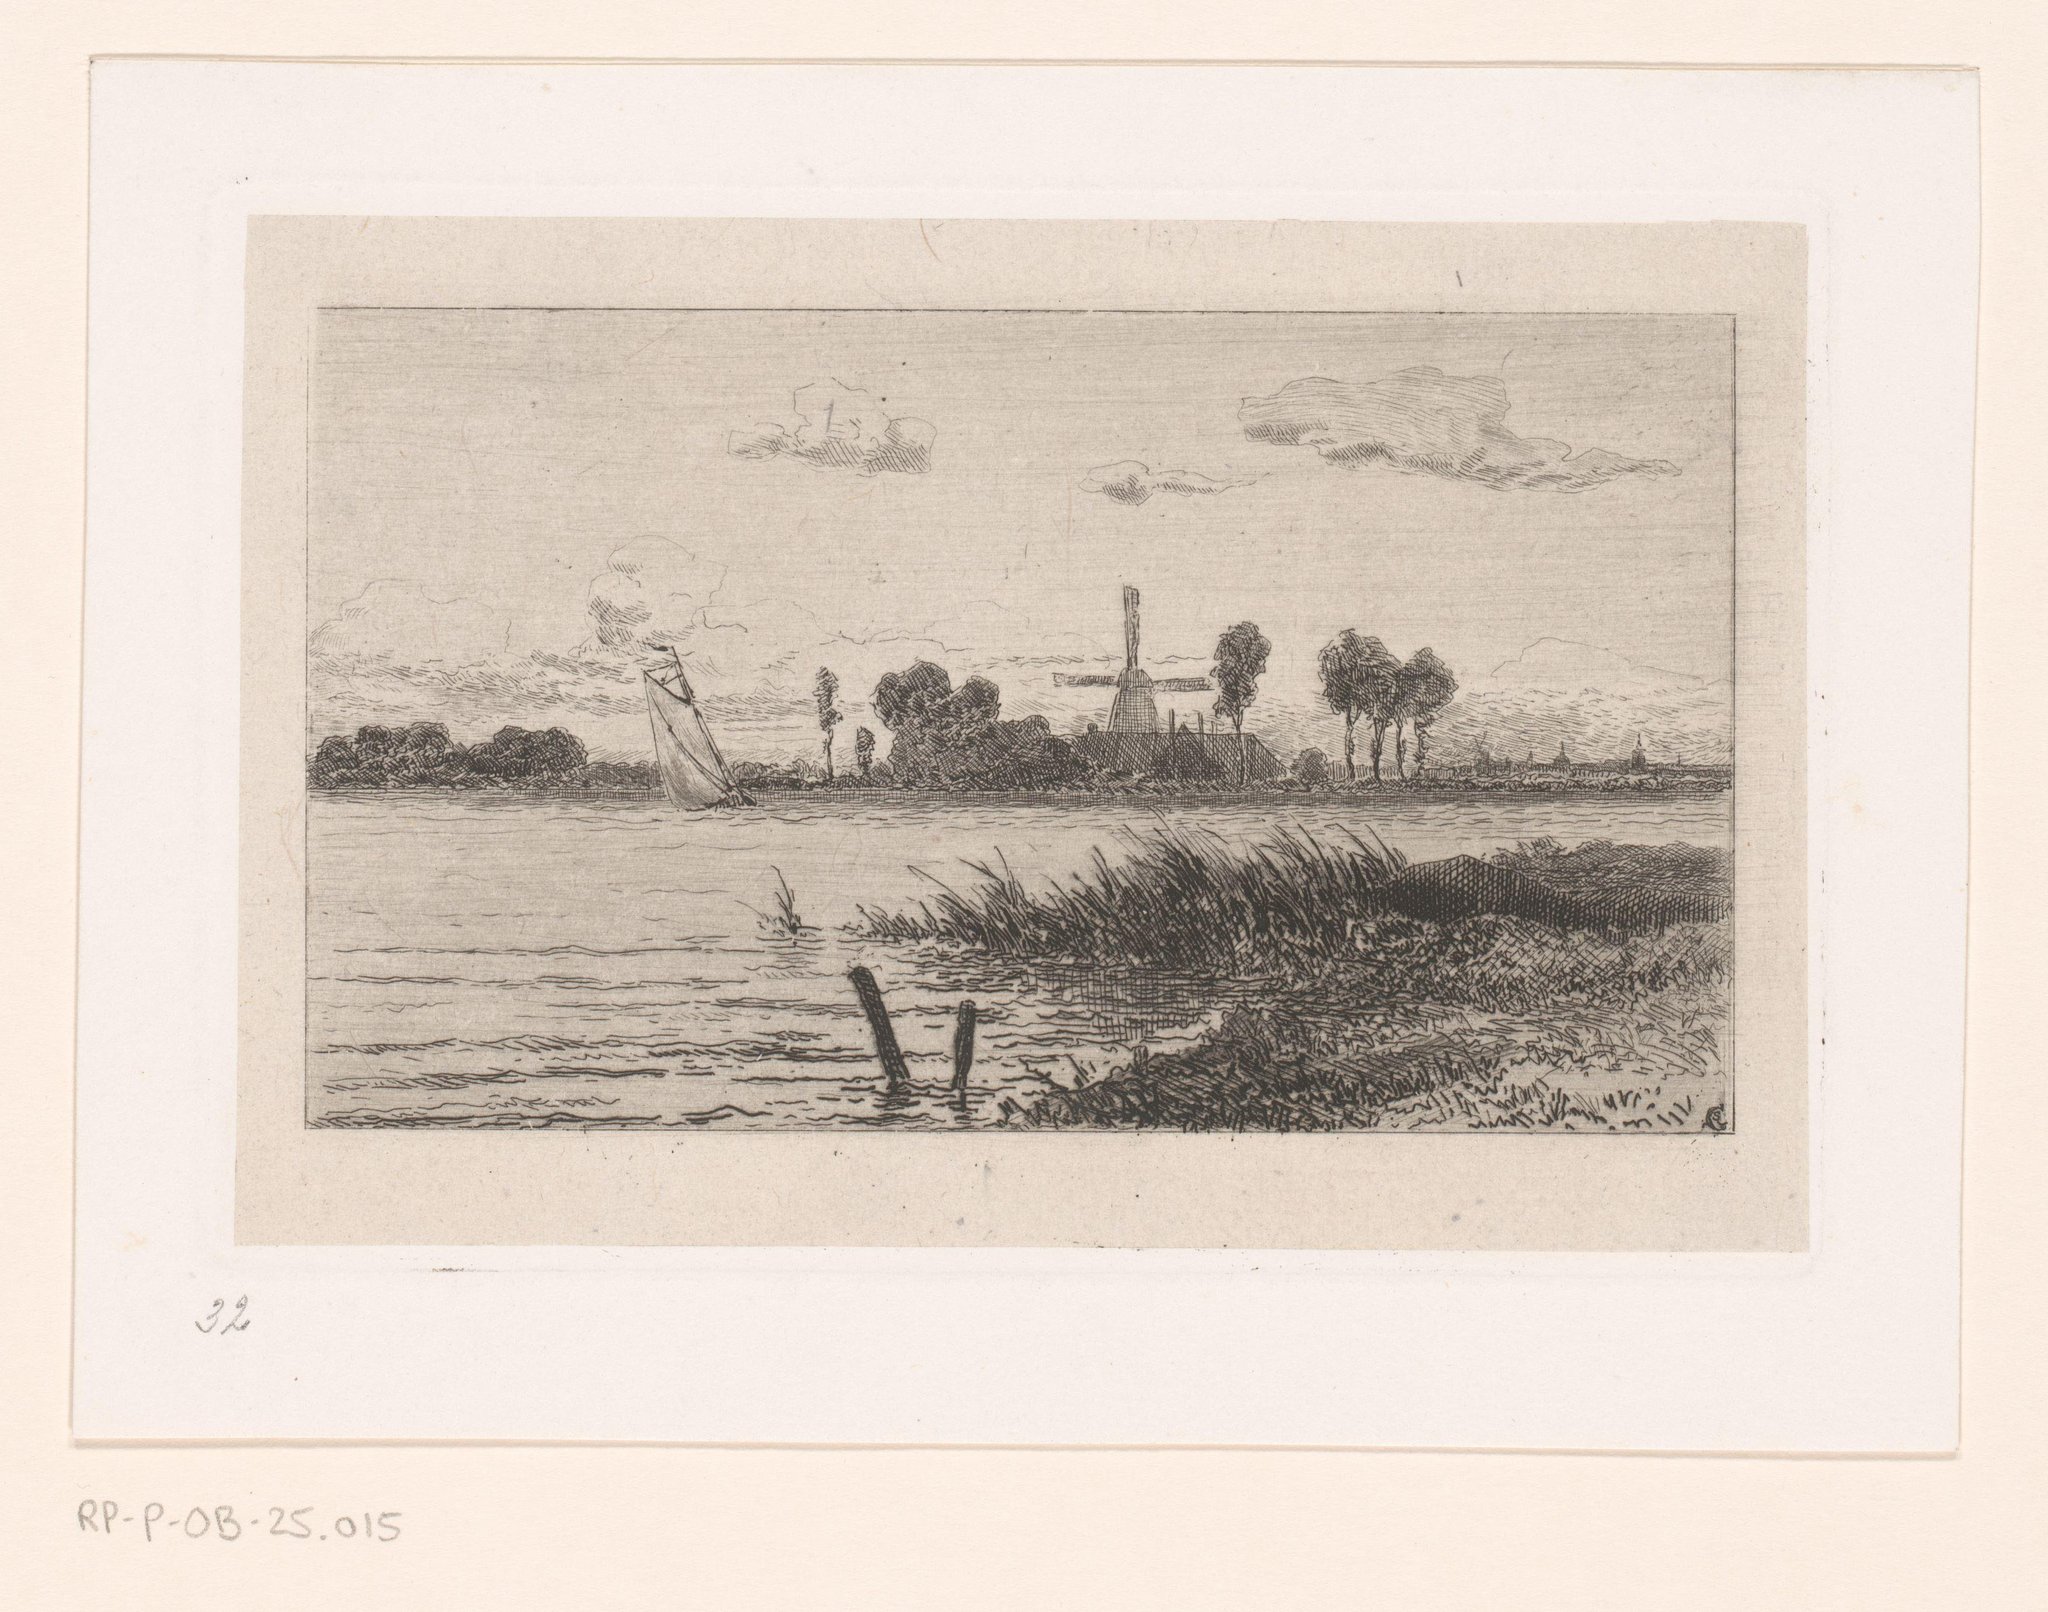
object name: print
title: Abcoudermeer met zeilboot en molen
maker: carel nicolaas storm van s-gravesande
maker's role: draughtsman, print maker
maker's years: 1841-1924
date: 1872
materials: paper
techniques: etching, intaglio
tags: lake, windmill in landscape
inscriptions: collector's mark: Lugt 2228